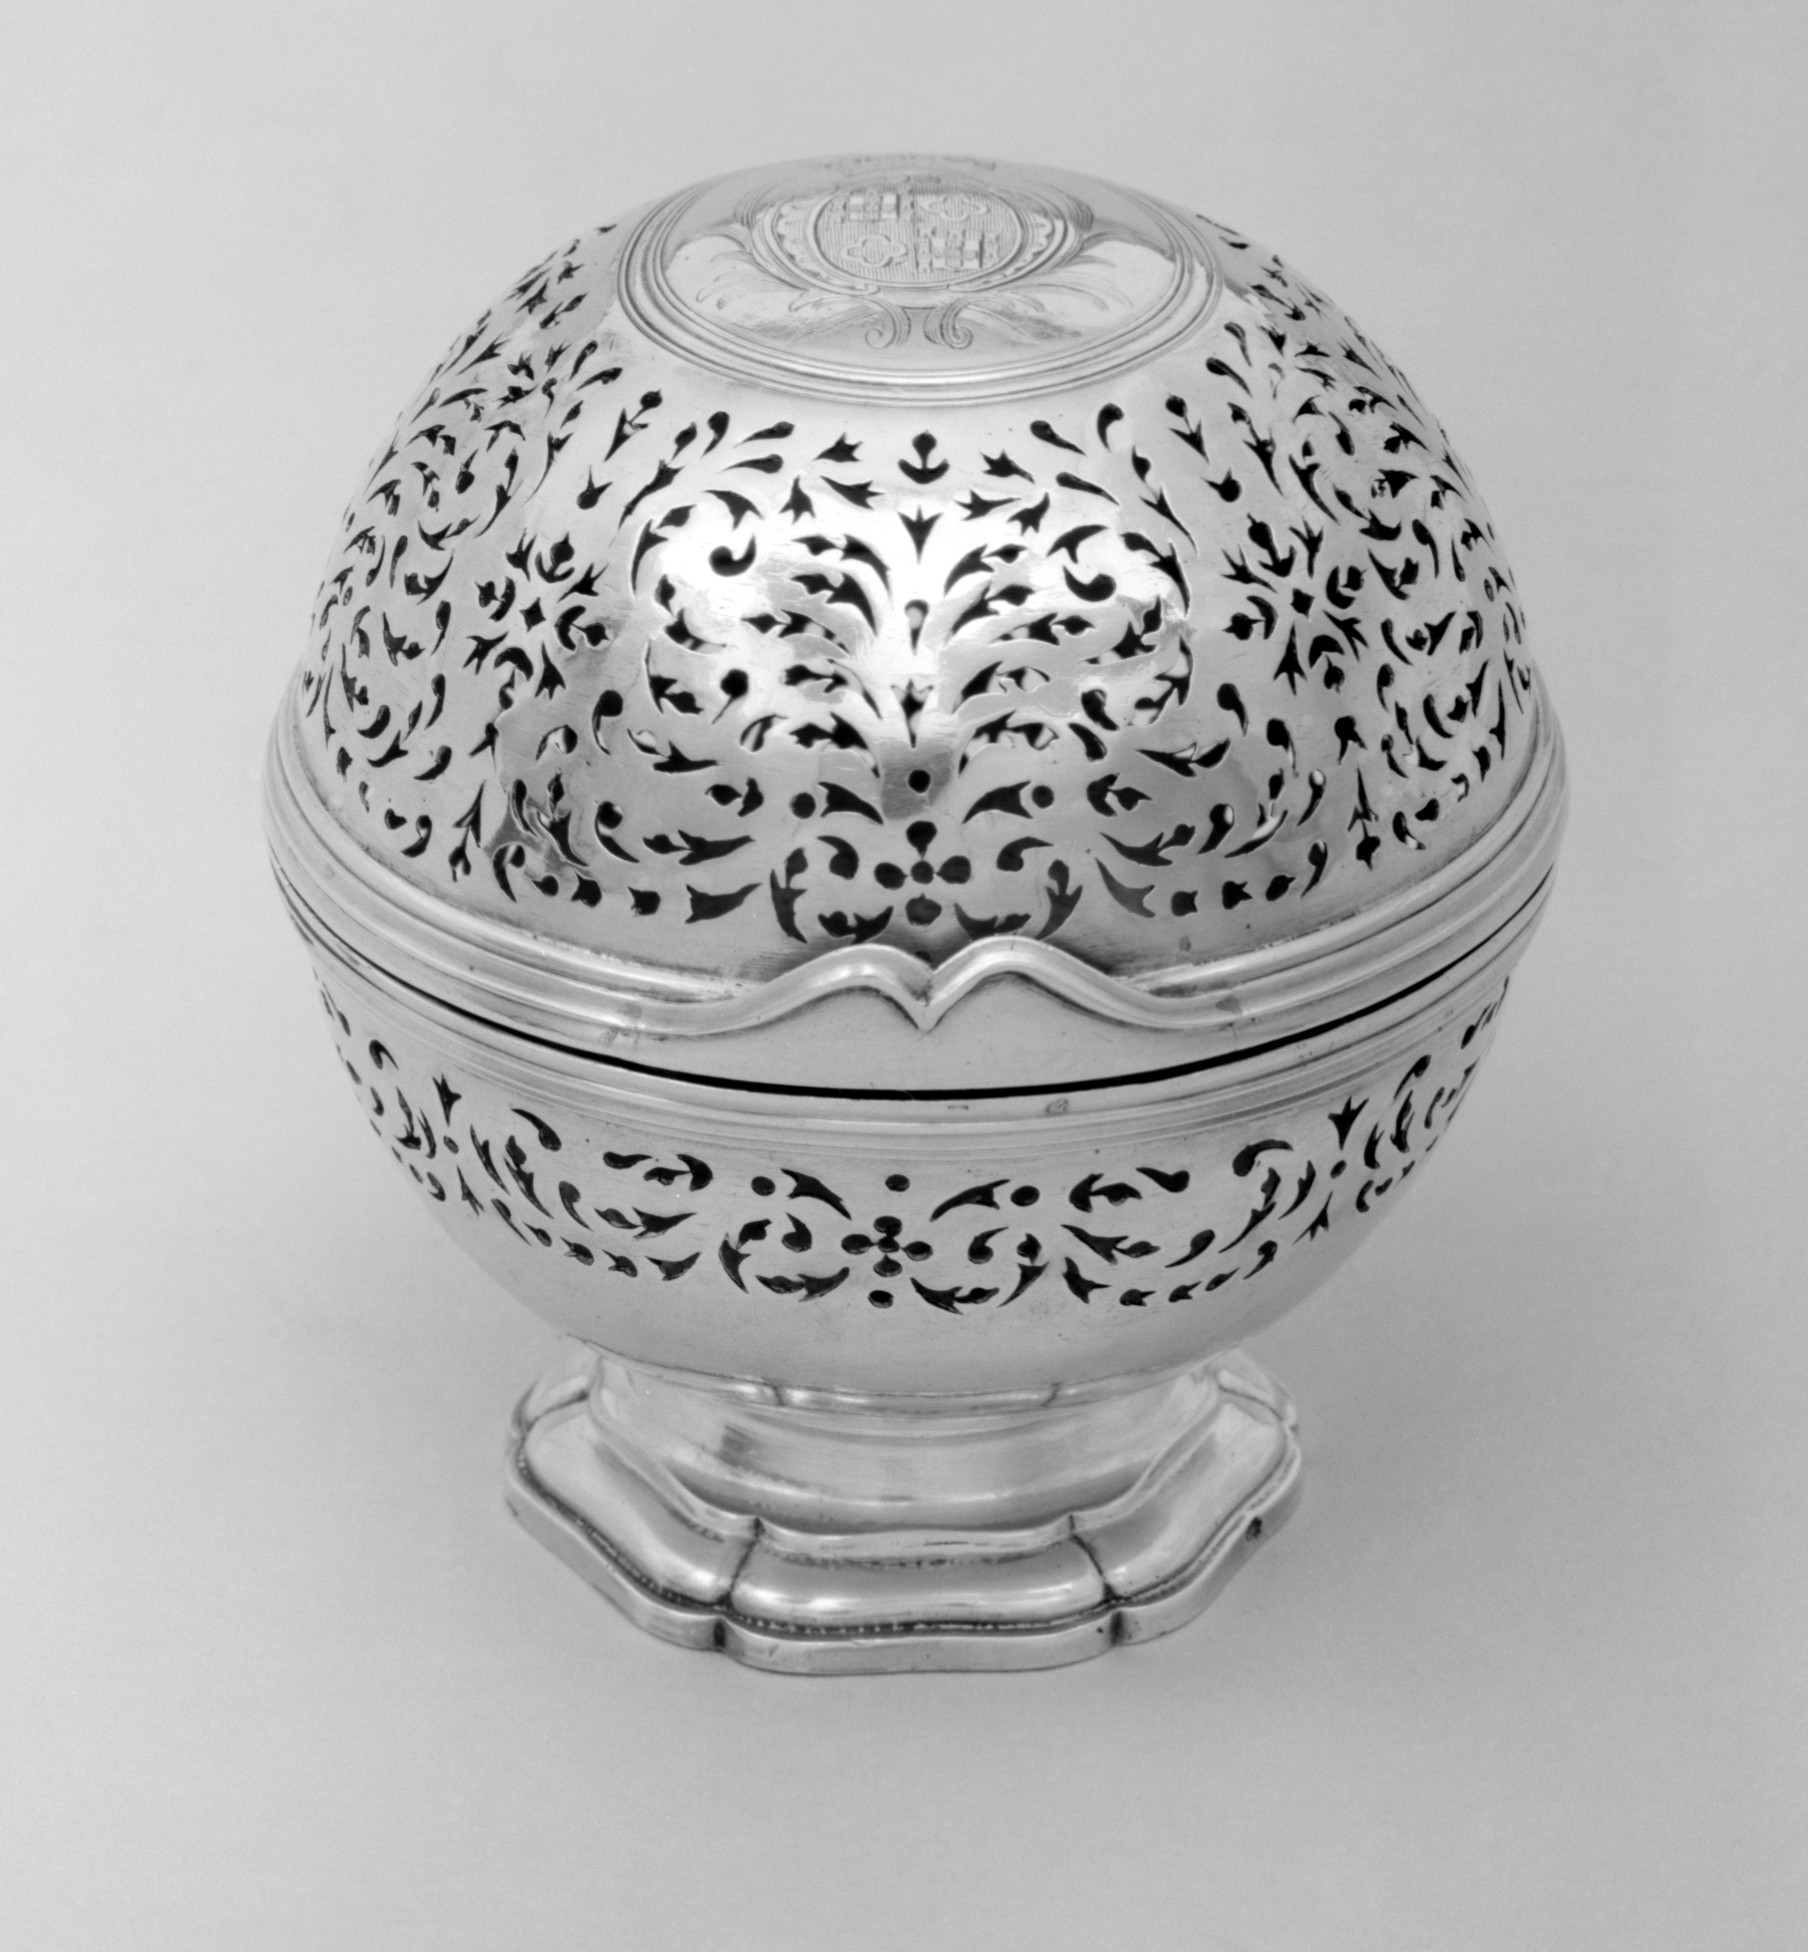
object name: sponge box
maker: henry allain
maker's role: maker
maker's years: 1745-1759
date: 1753-1754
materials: silver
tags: coat of arms